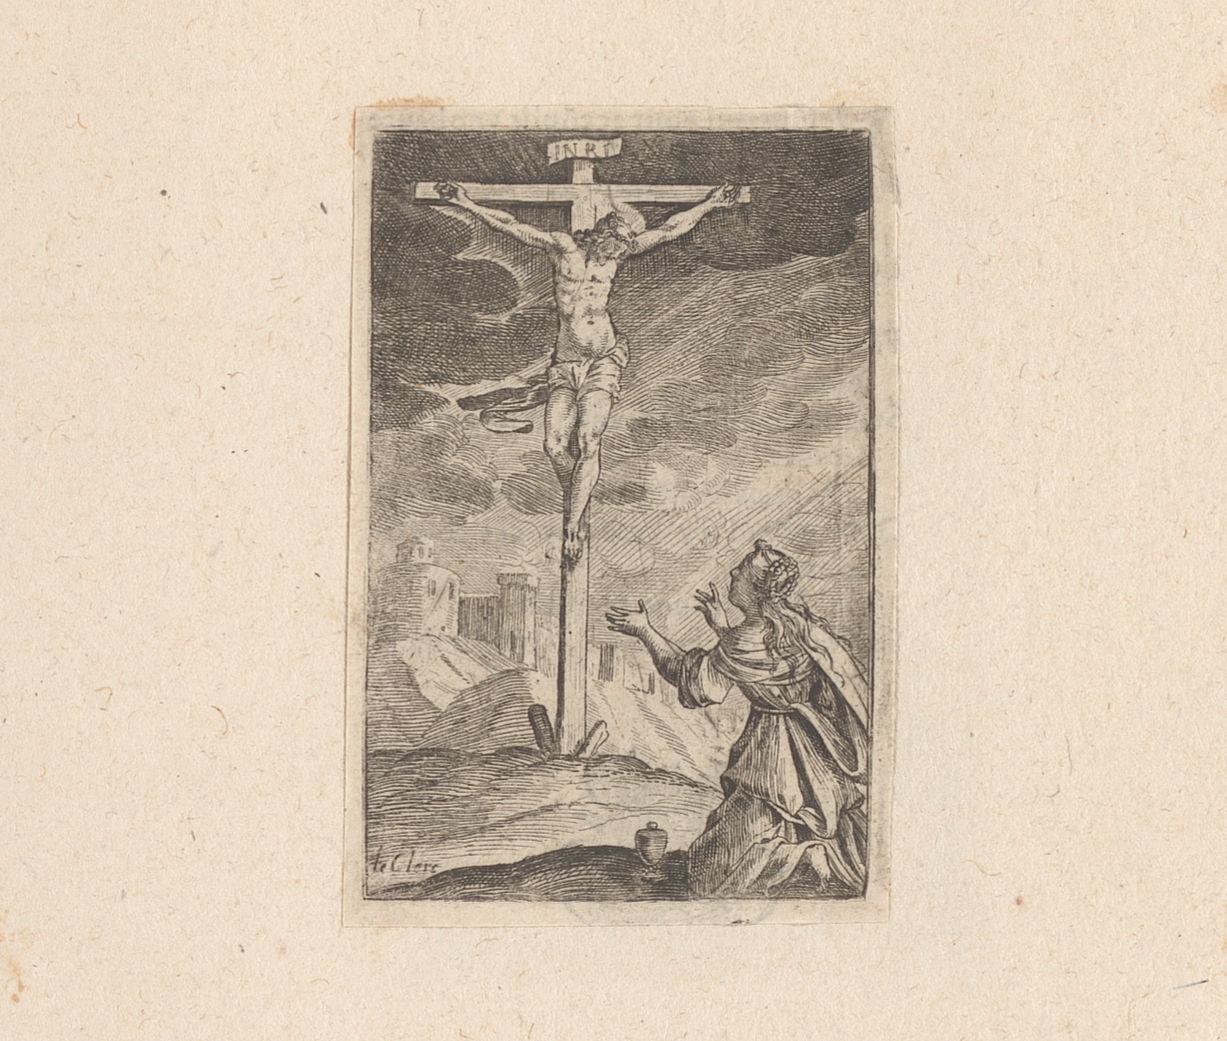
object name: print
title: Kruisiging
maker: sébastien leclerc (i)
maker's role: print maker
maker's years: 1637-1714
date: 1654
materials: paper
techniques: etching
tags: the crucifixion of christ: christ's death on the cross; golgotha (matthew 27:45-58; mark 15:33-45; luke 23:44-52; john 19:25-38)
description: Dit betreft een prent uit een gebedenboek met de titel 'Les Sept Offices avec les Litanies Dirigées (...)'.